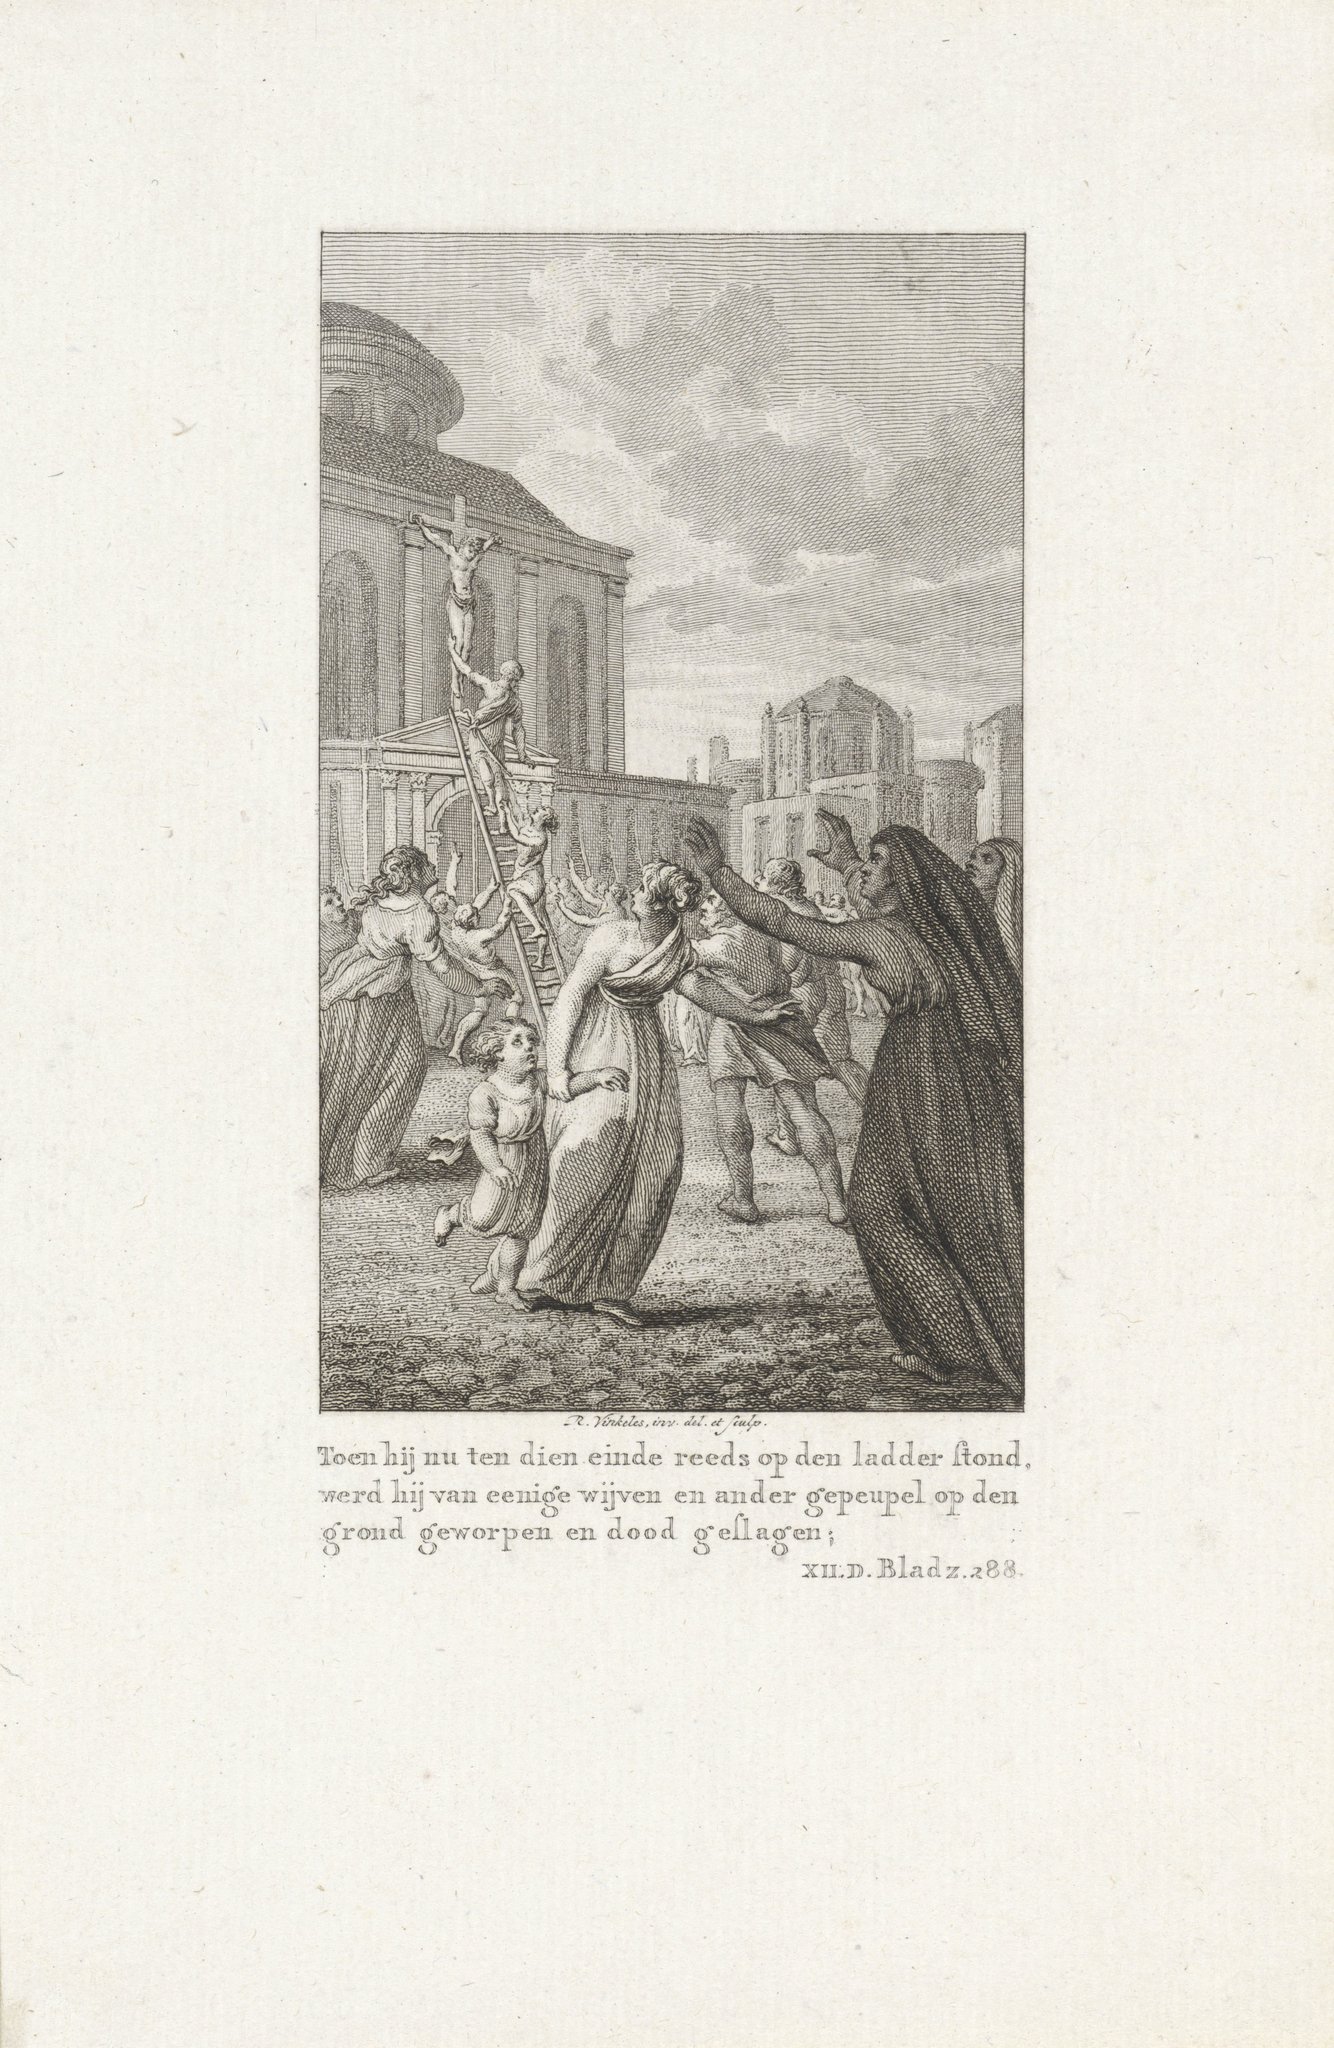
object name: print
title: Menigte probeert een man van een ladder te halen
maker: reinier vinkeles (i)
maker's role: draughtsman, print maker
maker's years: 1741-1816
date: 1806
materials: paper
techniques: engraving, etching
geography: amsterdam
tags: altarcross, crucifix, church (exterior), ladder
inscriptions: collector's mark: Lugt 240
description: Op een plein klimt een man op een ladder richting een aan een kerk bevestigd kruisbeeld. Een menigte rent naar hem toe en probeert hem naar beneden te halen.